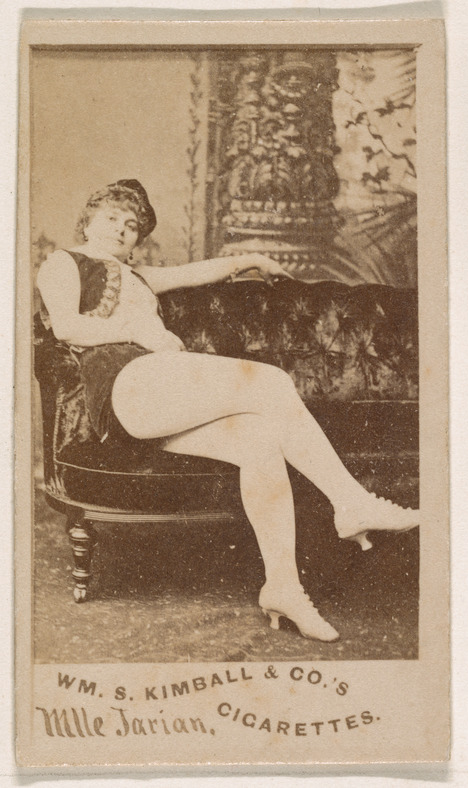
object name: photograph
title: Mlle. Jarian, from the Actresses series (N203) issued by Wm. S. Kimball & Co.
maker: william s. kimball & company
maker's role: publisher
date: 1889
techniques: color lithograph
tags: portraits,women,actresses